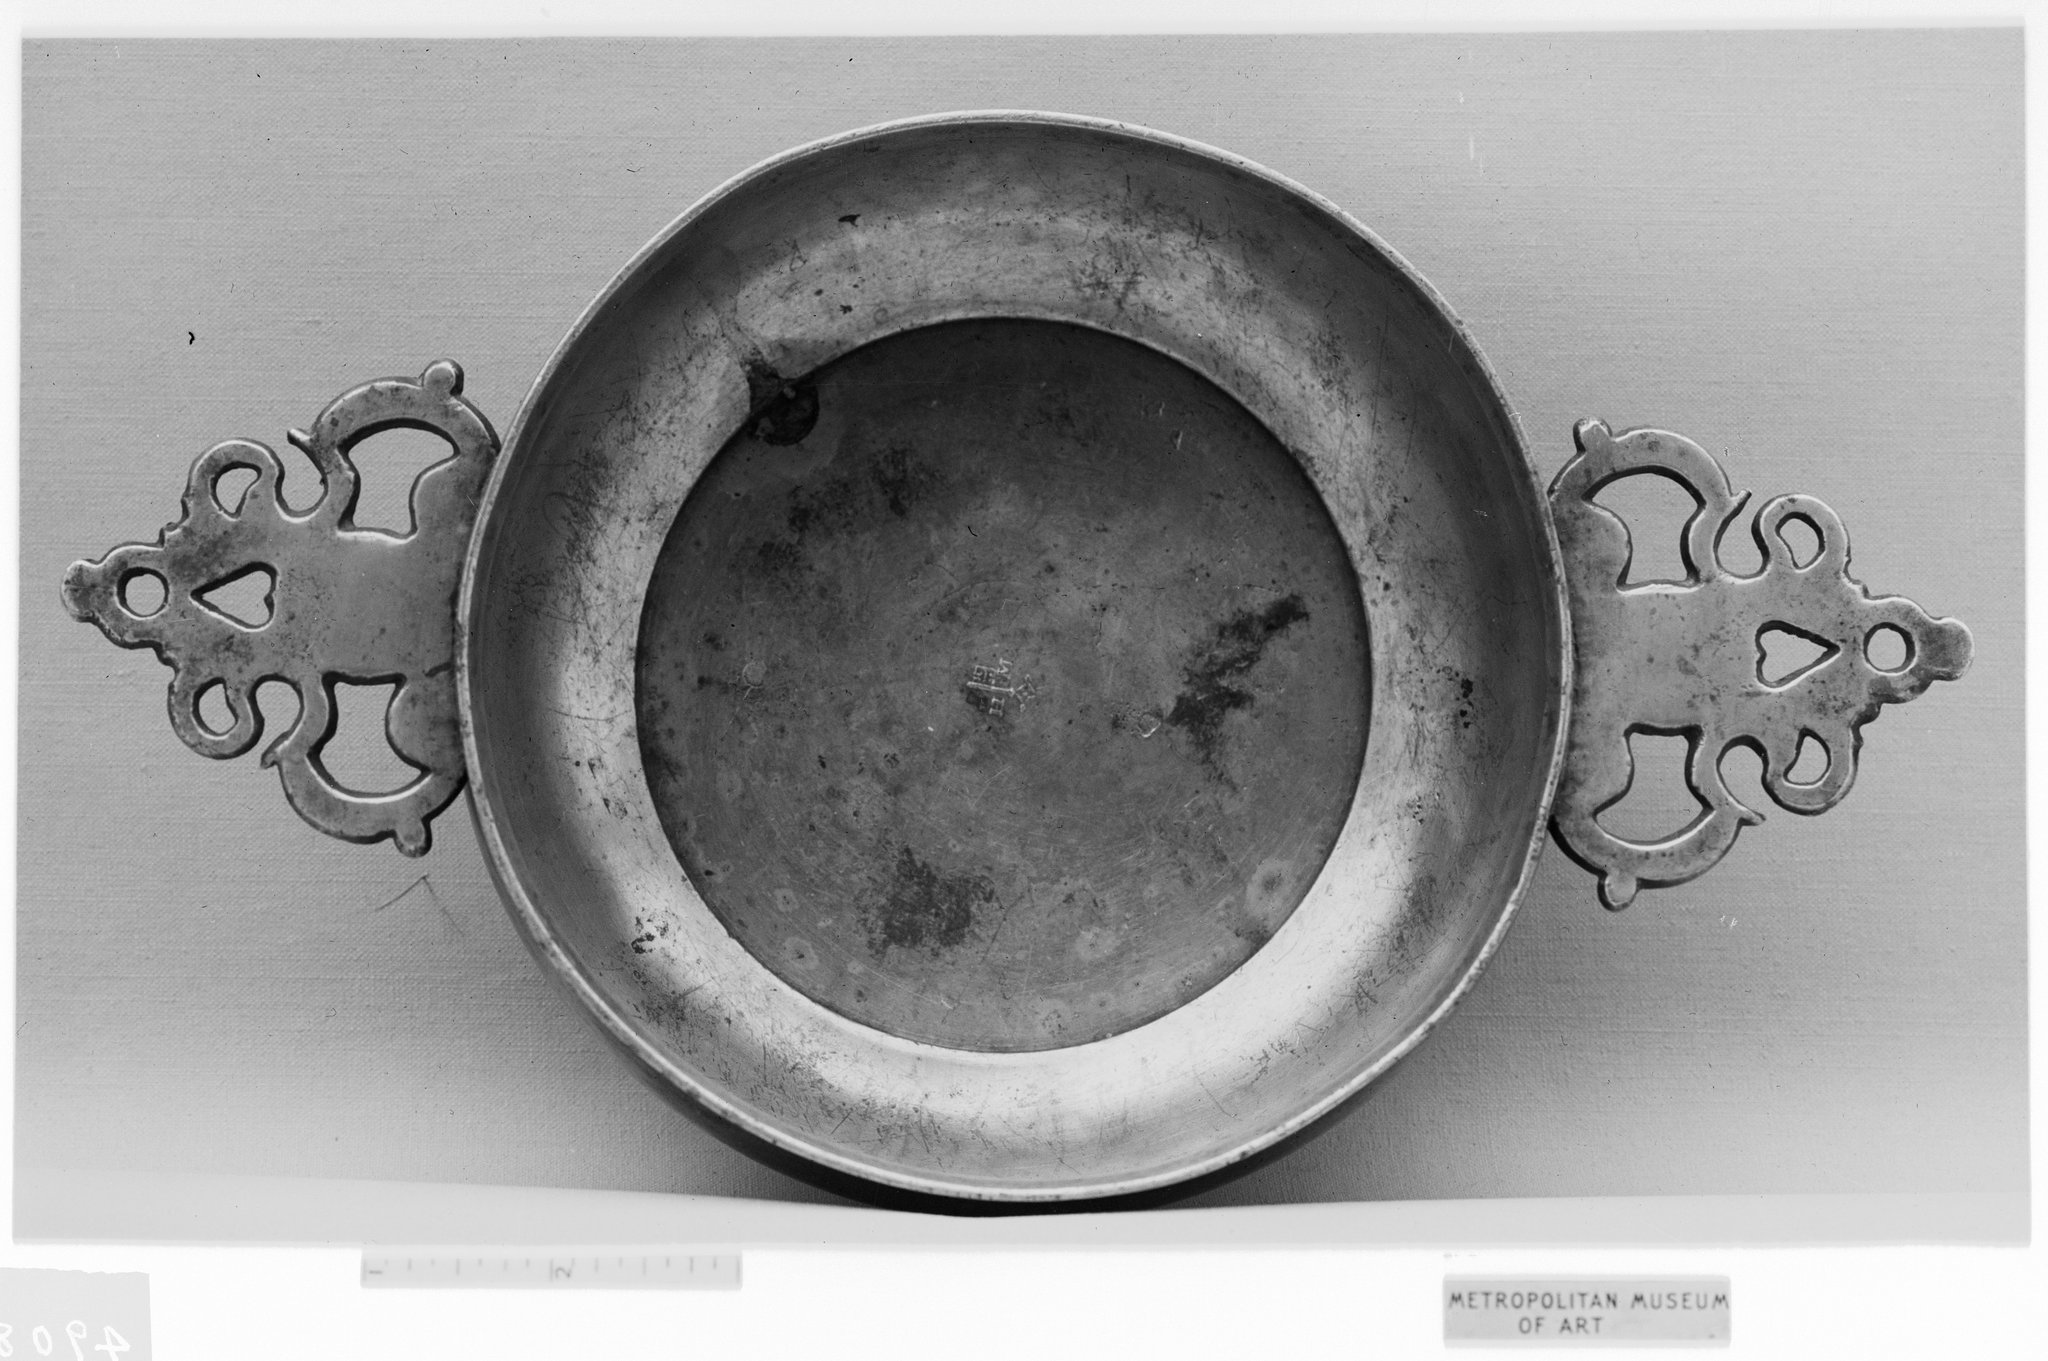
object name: porringer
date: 1601-1700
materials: pewter